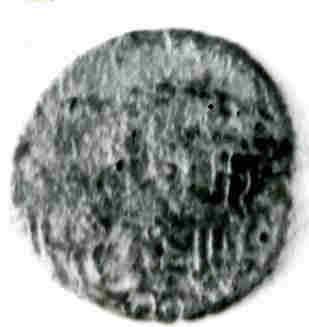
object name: coin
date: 401-1400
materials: copper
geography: iran